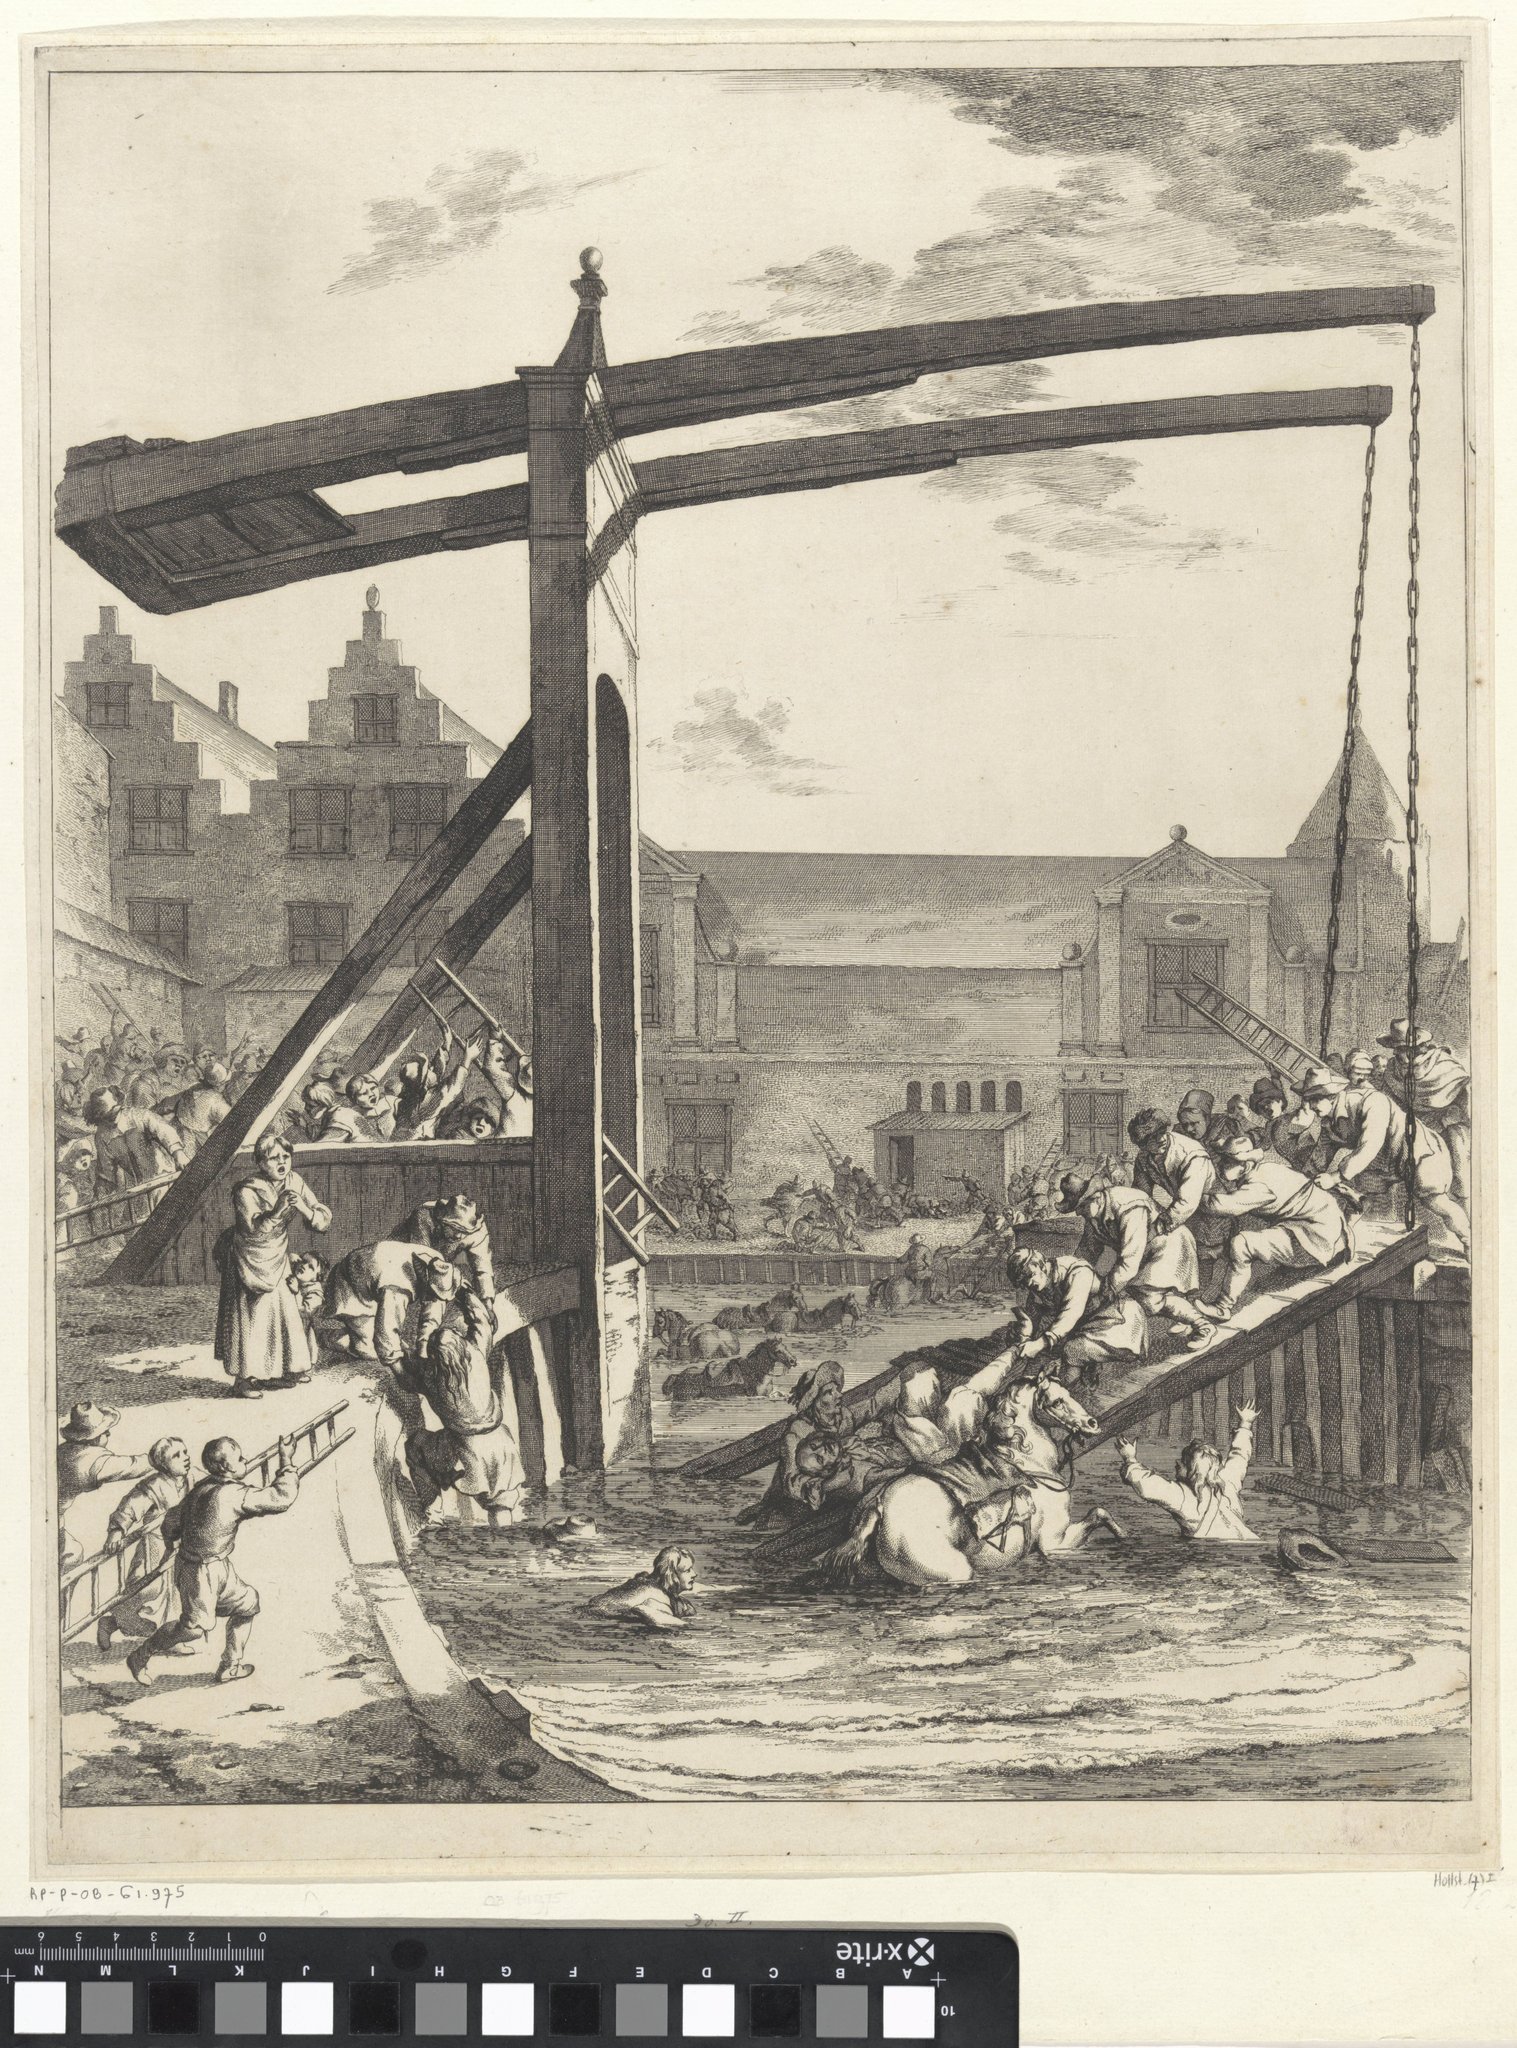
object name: print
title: Redding van graaf Johan Maurits na het ongeluk op de brug van Franeker, 1665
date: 1665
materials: paper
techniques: etching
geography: northern netherlands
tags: earl, johan maurits graaf van nassau-siegen, collapsing building, bridge, accident with horse (or kindred animal), saving a person from drowning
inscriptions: collector's mark: Lugt 12, collector's mark: Lugt 573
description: Redding van graaf Johan Maurits na het ongeluk op de brug van Franeker, 1665, 6 januari 1665. De ophaalbrug waar de graaf met zijn gevolg overheen reed is ingestort. De graaf wordt uit het water gehaald, omstanders komen met ladders aangesneld.